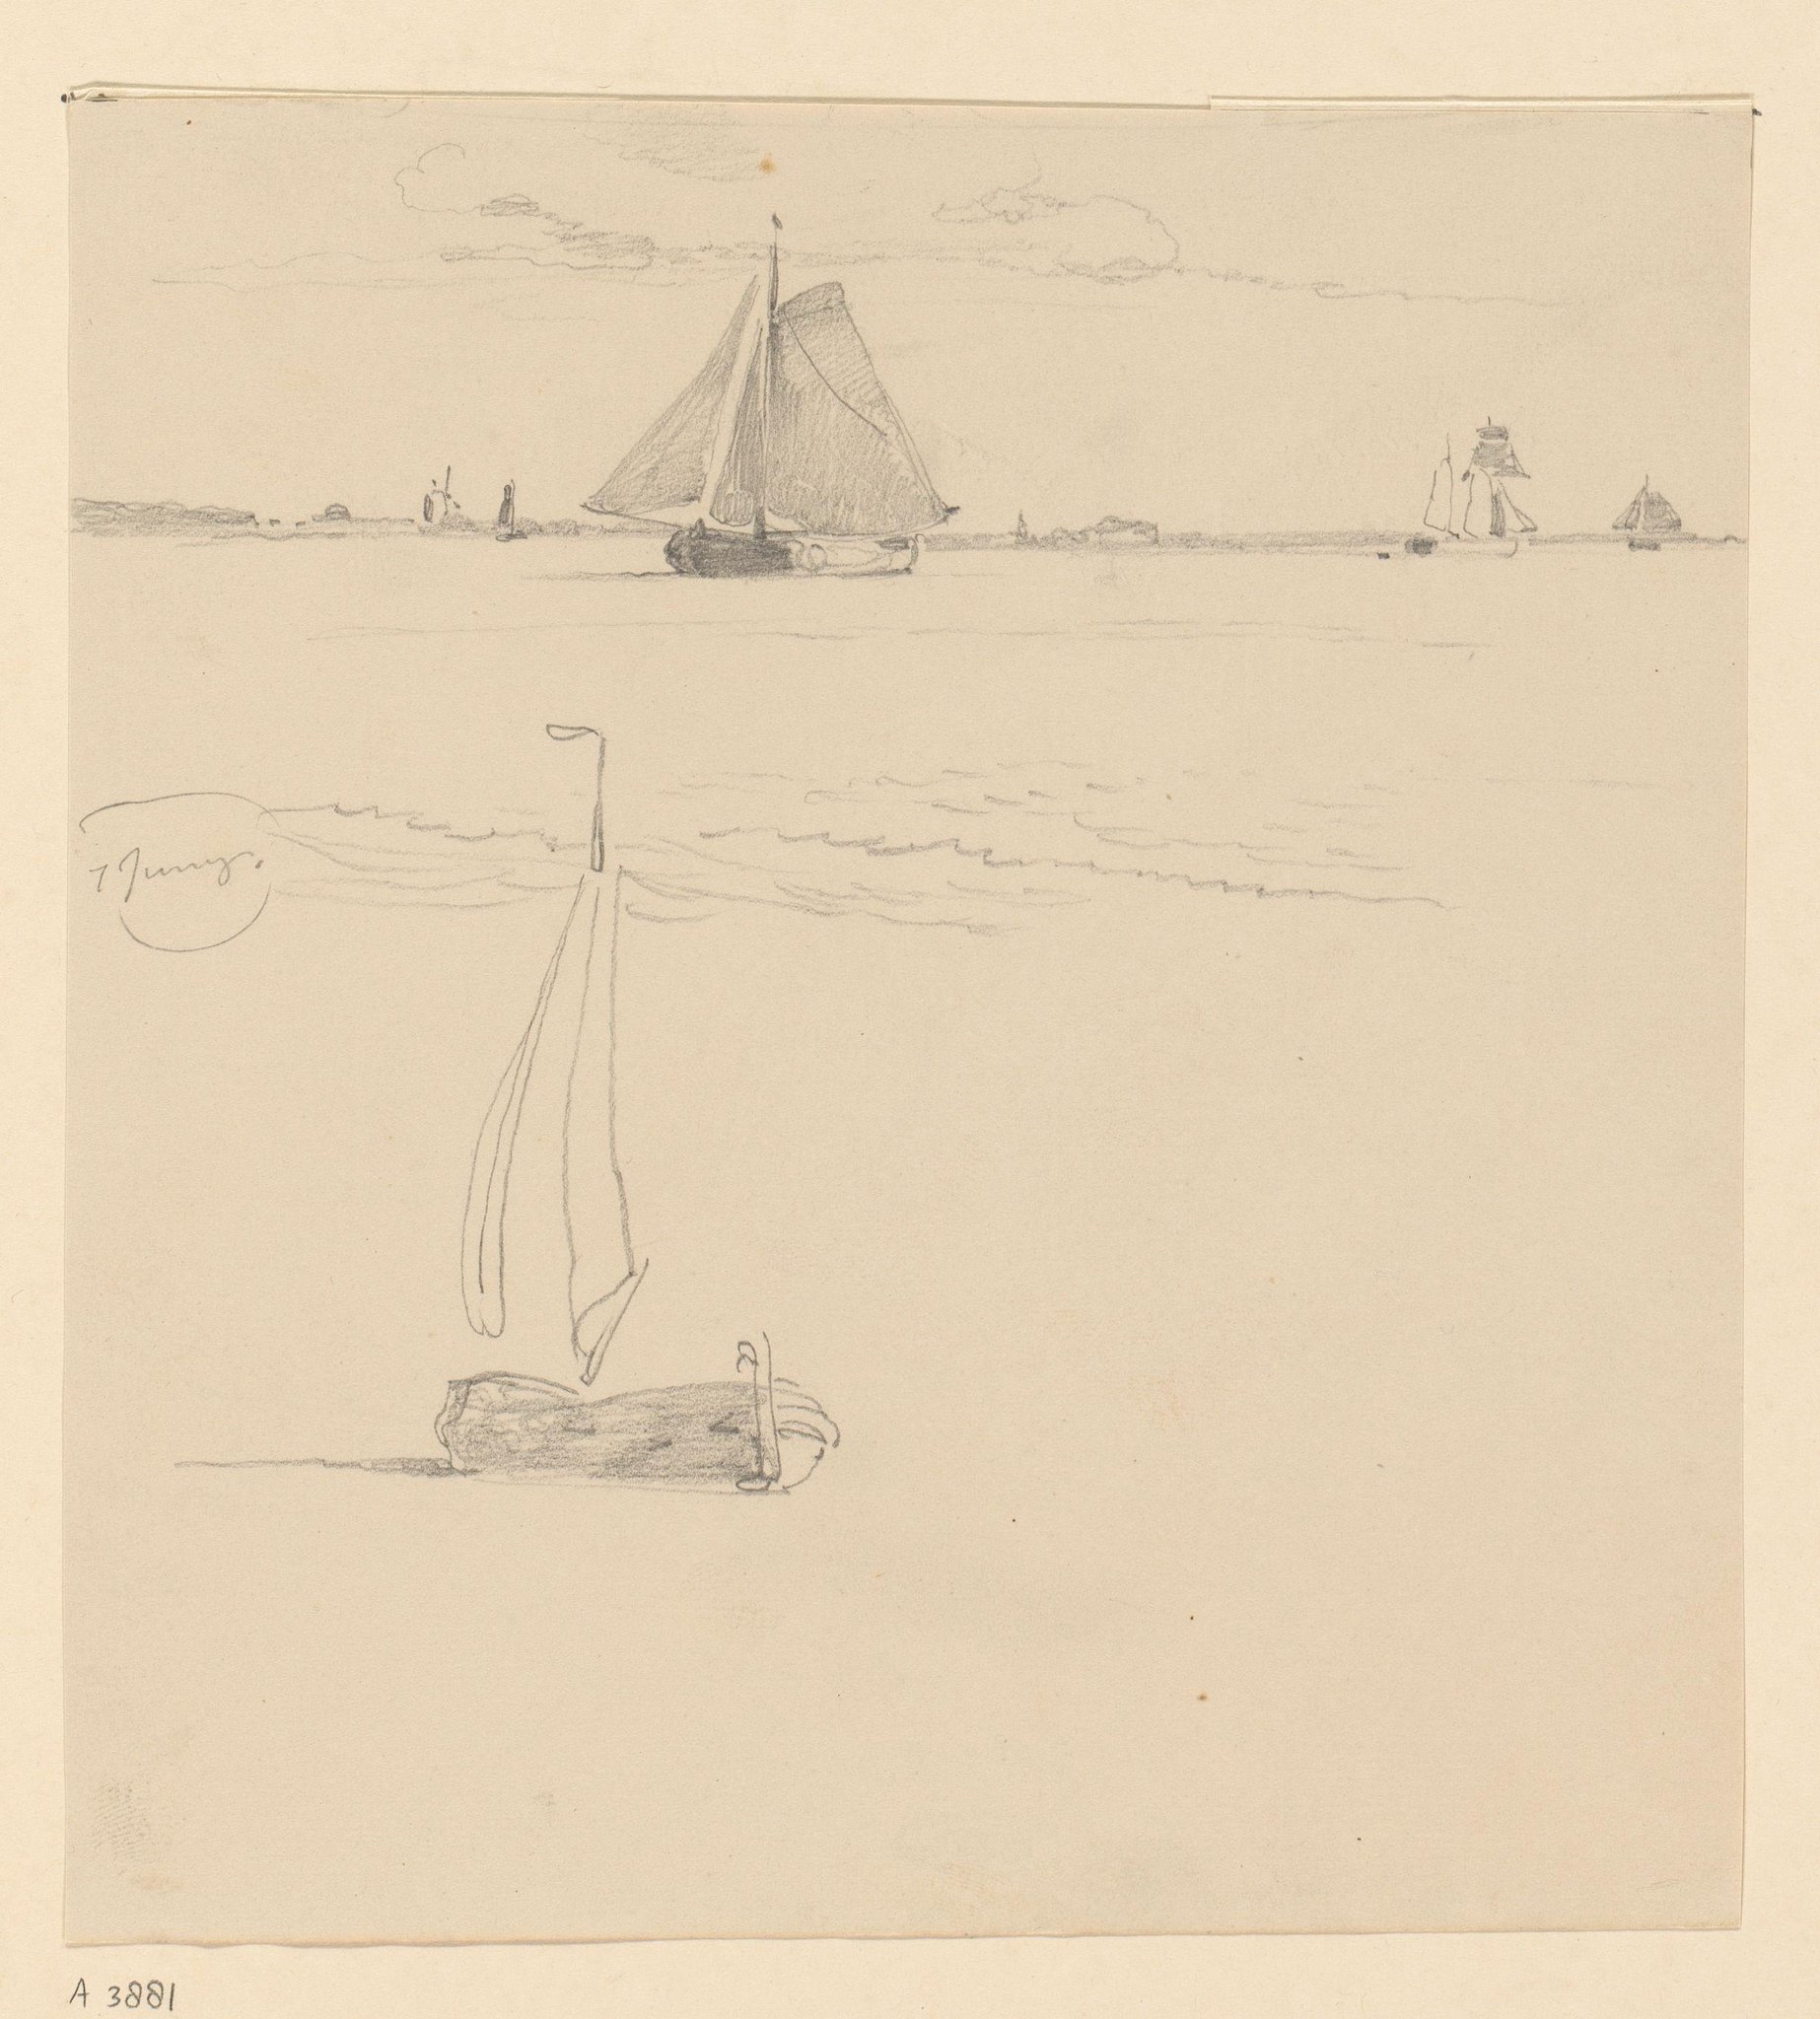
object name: drawing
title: Twee schetsen met vissersboten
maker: willem anthonie van deventer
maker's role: draughtsman, painter, print maker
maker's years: 1824-1893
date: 1834-1893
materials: paper, pencil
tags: sailing-ship, sailing-boat